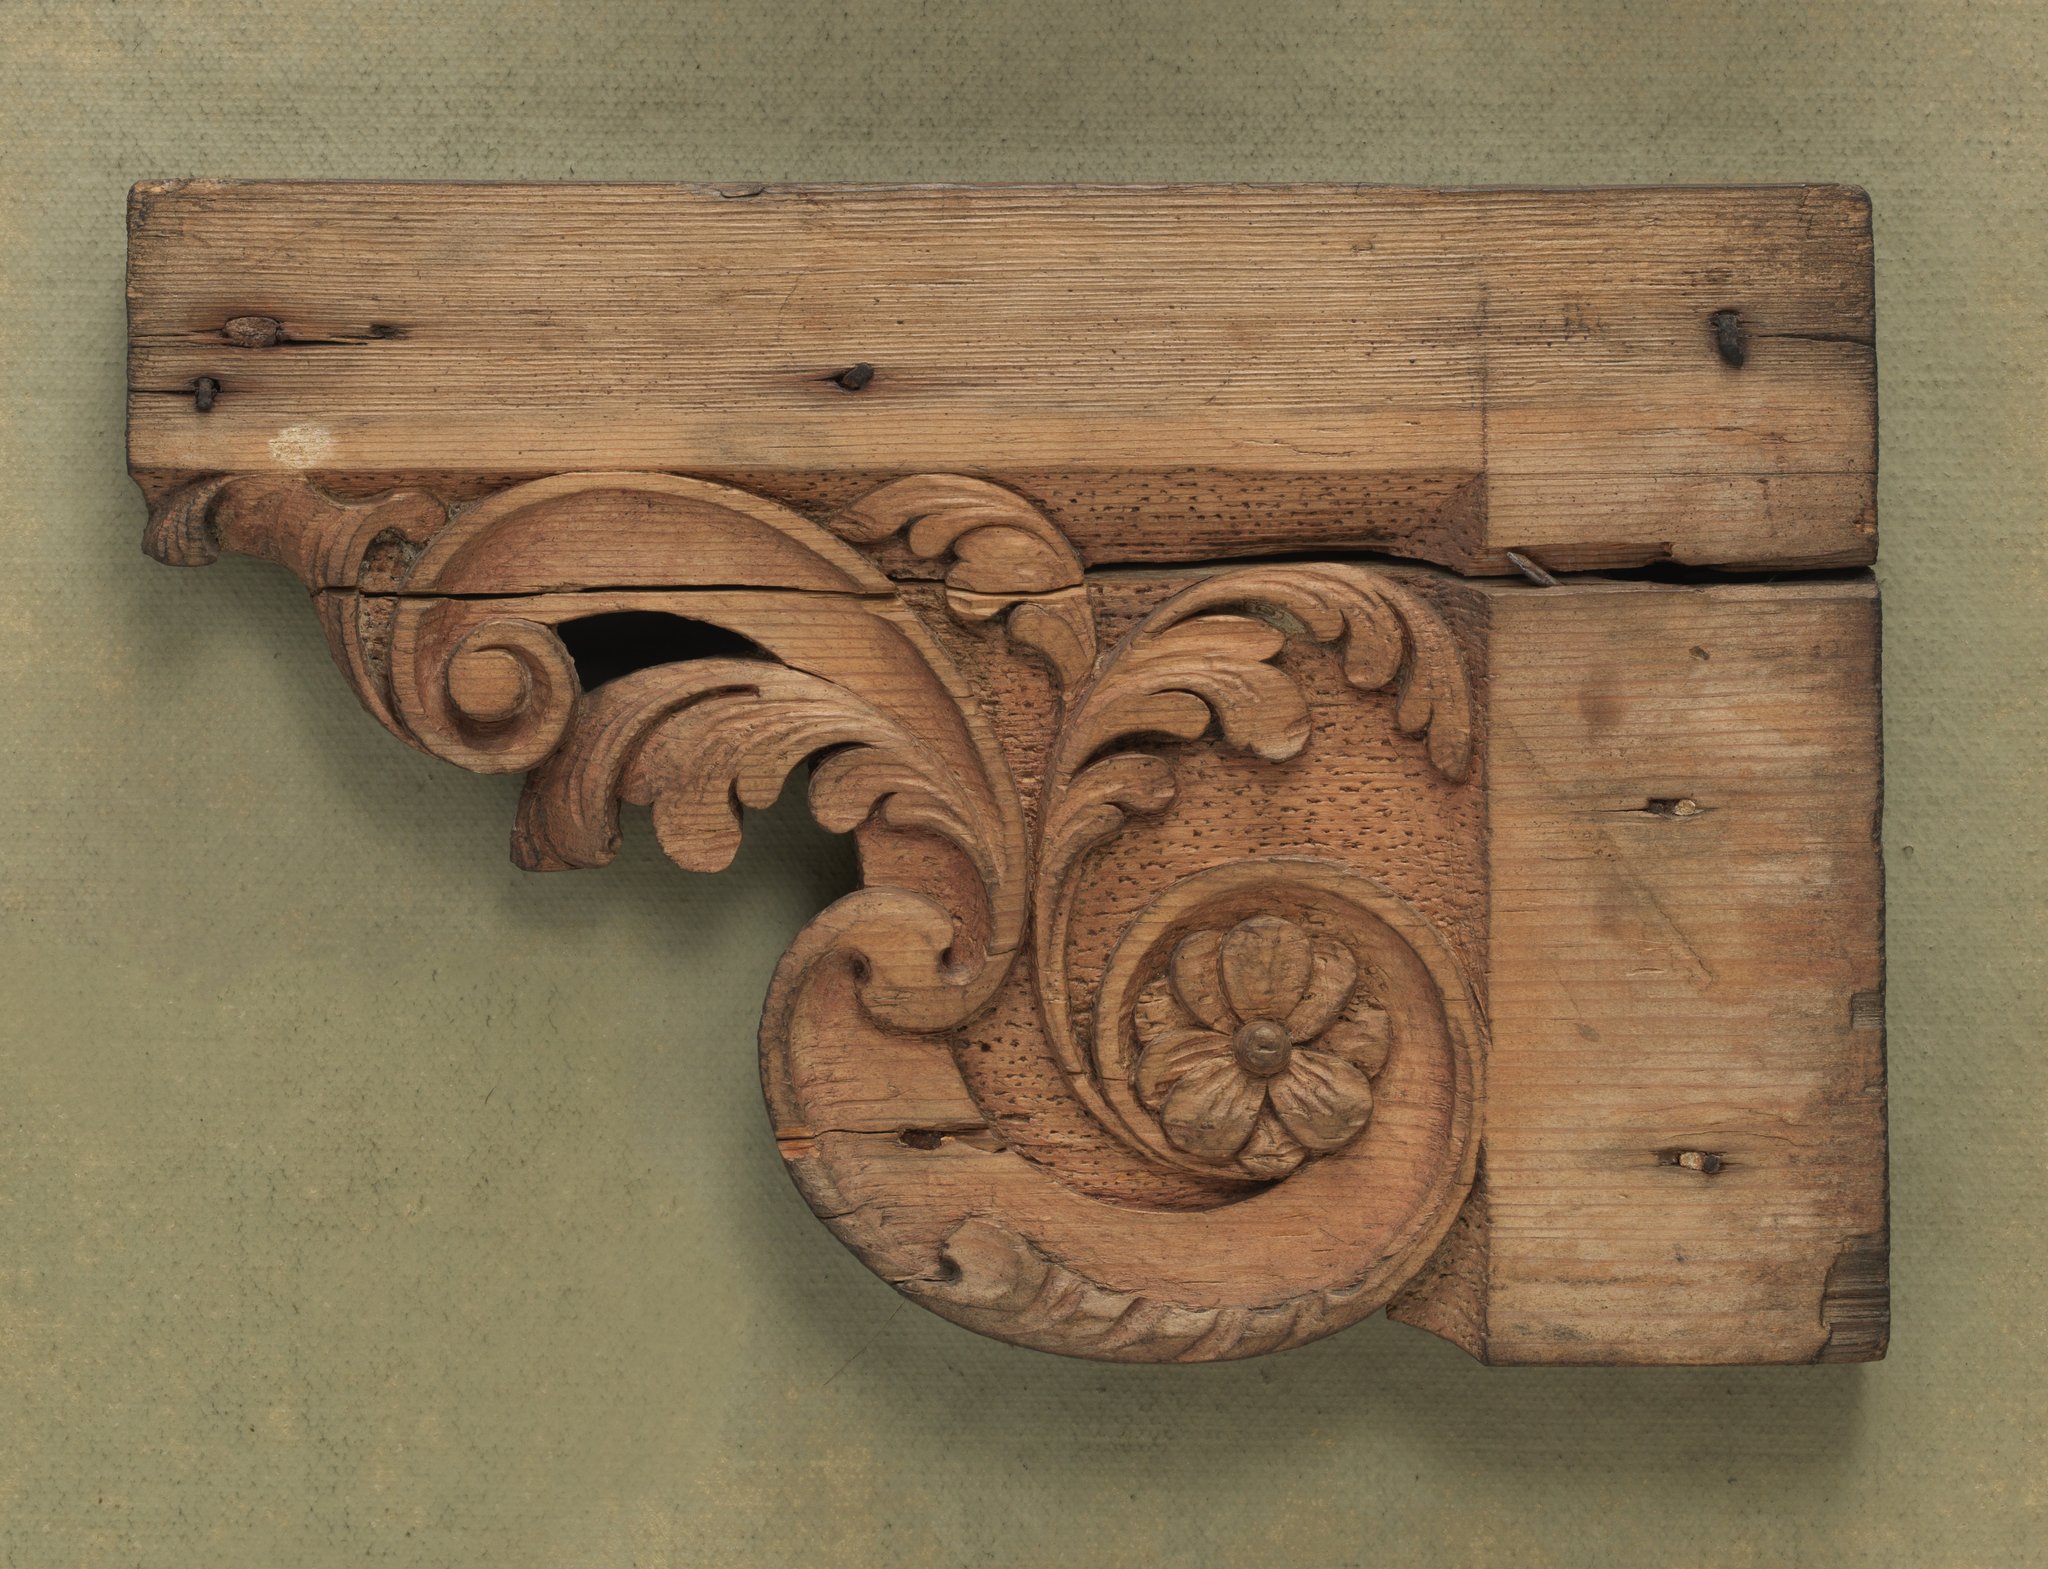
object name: bracket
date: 1701-1800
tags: flowers